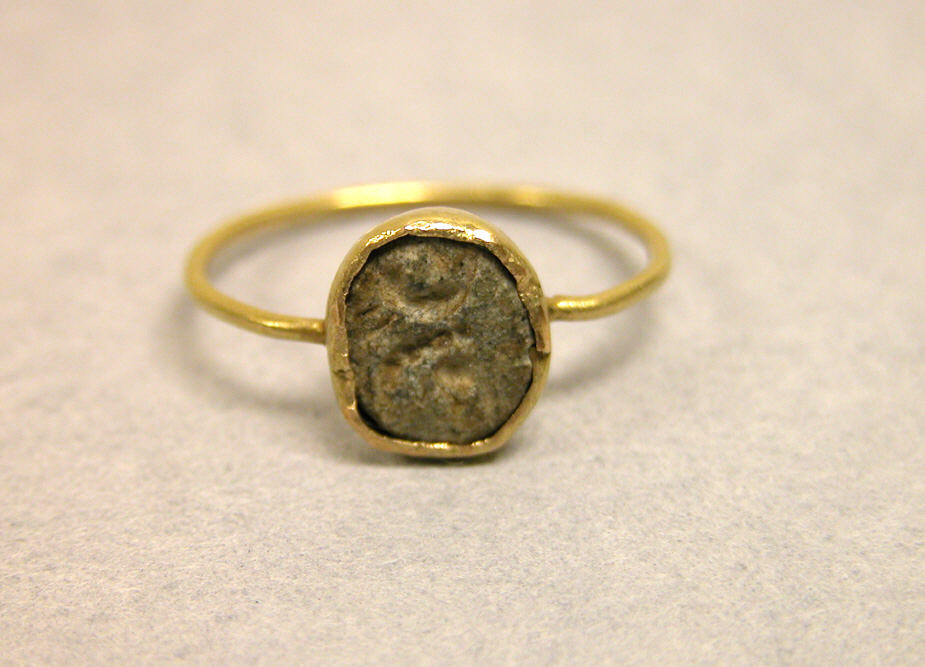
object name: ring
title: Engraved Ring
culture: indonesian, central java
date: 701-1200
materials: gold